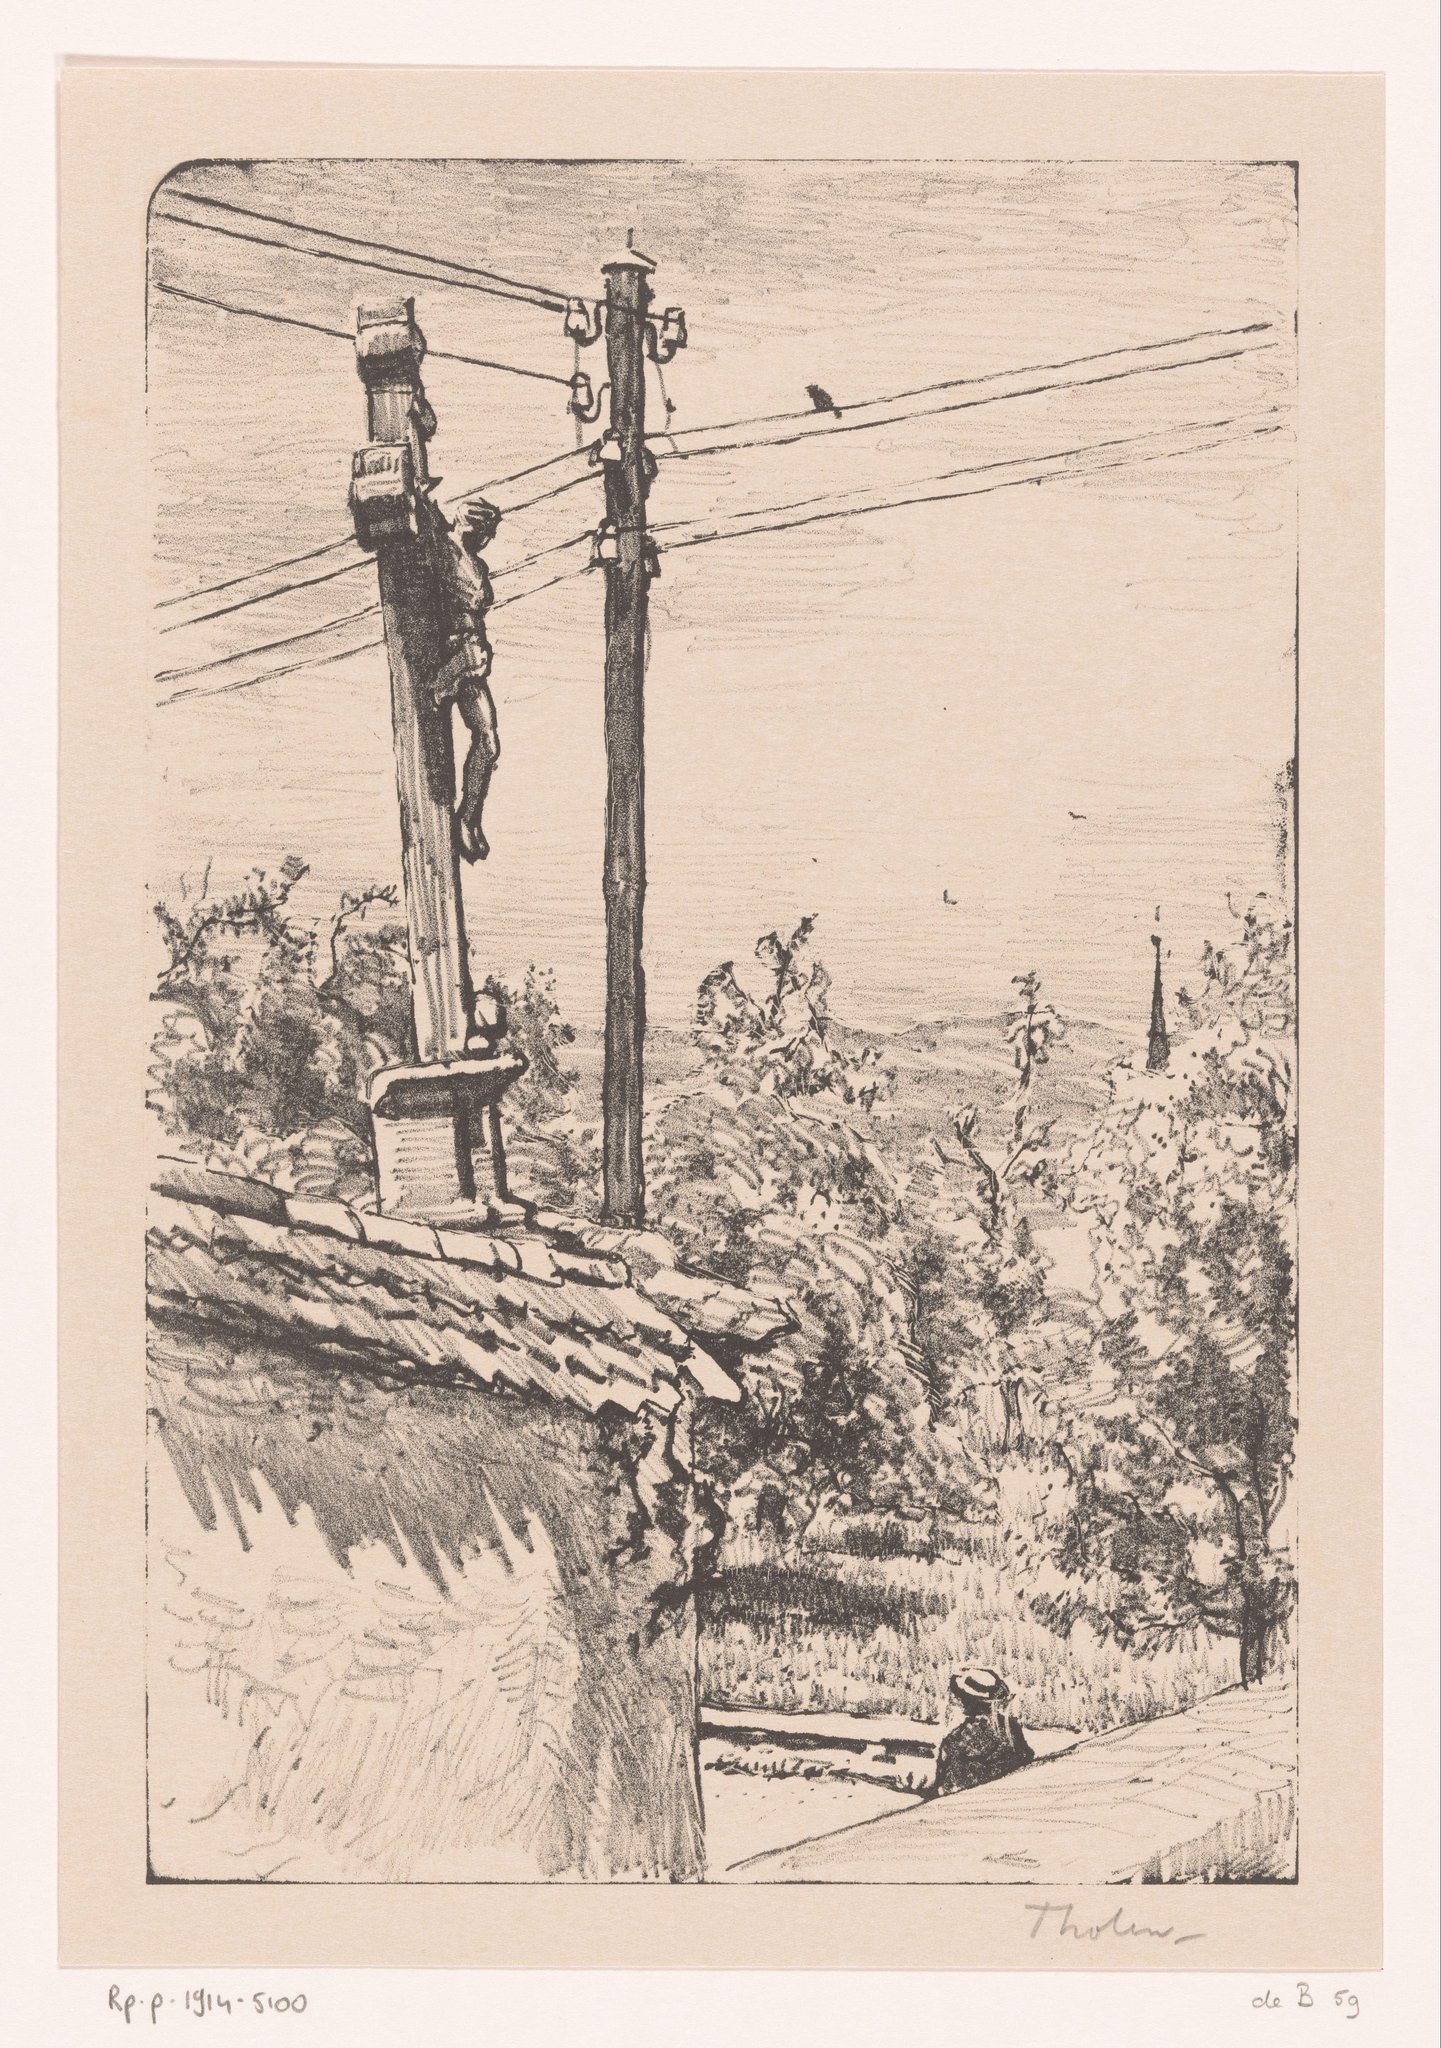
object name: print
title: Kruis en telegraafpaal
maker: willem bastiaan tholen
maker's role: draughtsman, painter, print maker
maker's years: 1860-1931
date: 1870-1914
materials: paper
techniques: lithograph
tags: low hill country, telegraph pole, telephone pole, crucifix ~ personal devotion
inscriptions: collector's mark: Lugt 2233